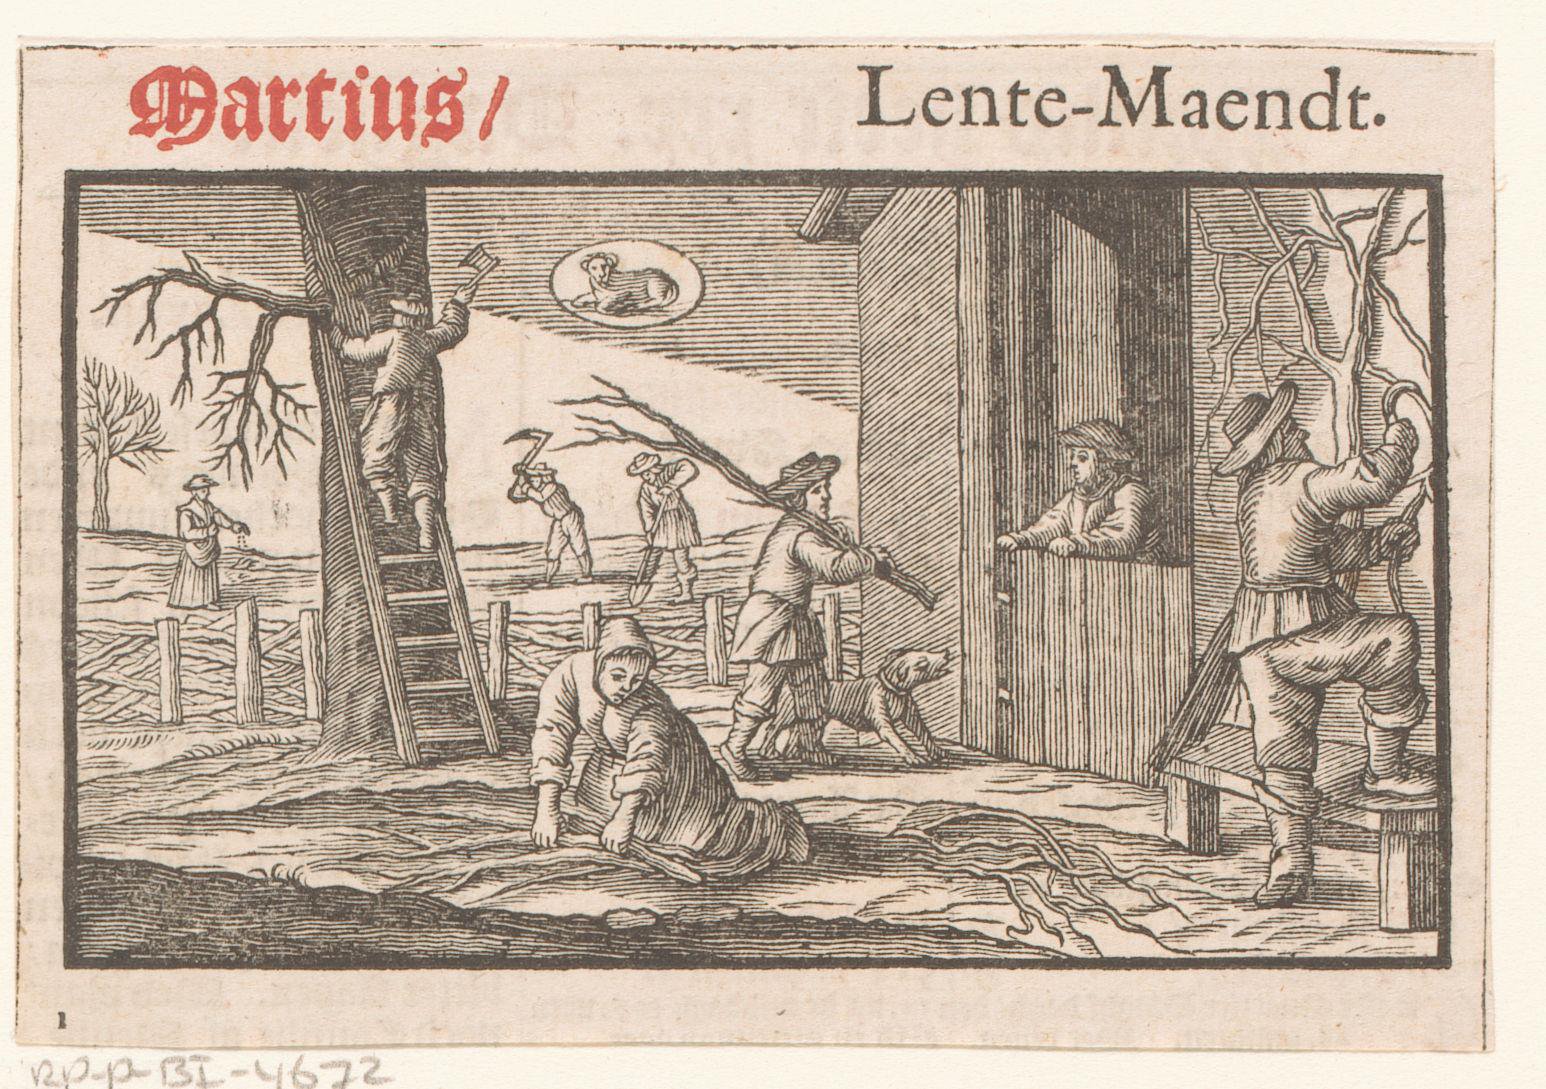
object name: book illustration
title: Maanden van het jaar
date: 1664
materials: paper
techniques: letterpress printing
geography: netherlands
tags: march and its 'labours' (+ with aries (march)), garden, agriculture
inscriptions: collector's mark: Lugt 240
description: Prent uit: Saeghman, Gillis Joosten. Groote comptoir almanach op't schrickel-iaer. Amsterdam: Gillis Joosten Saeghman, 1664.